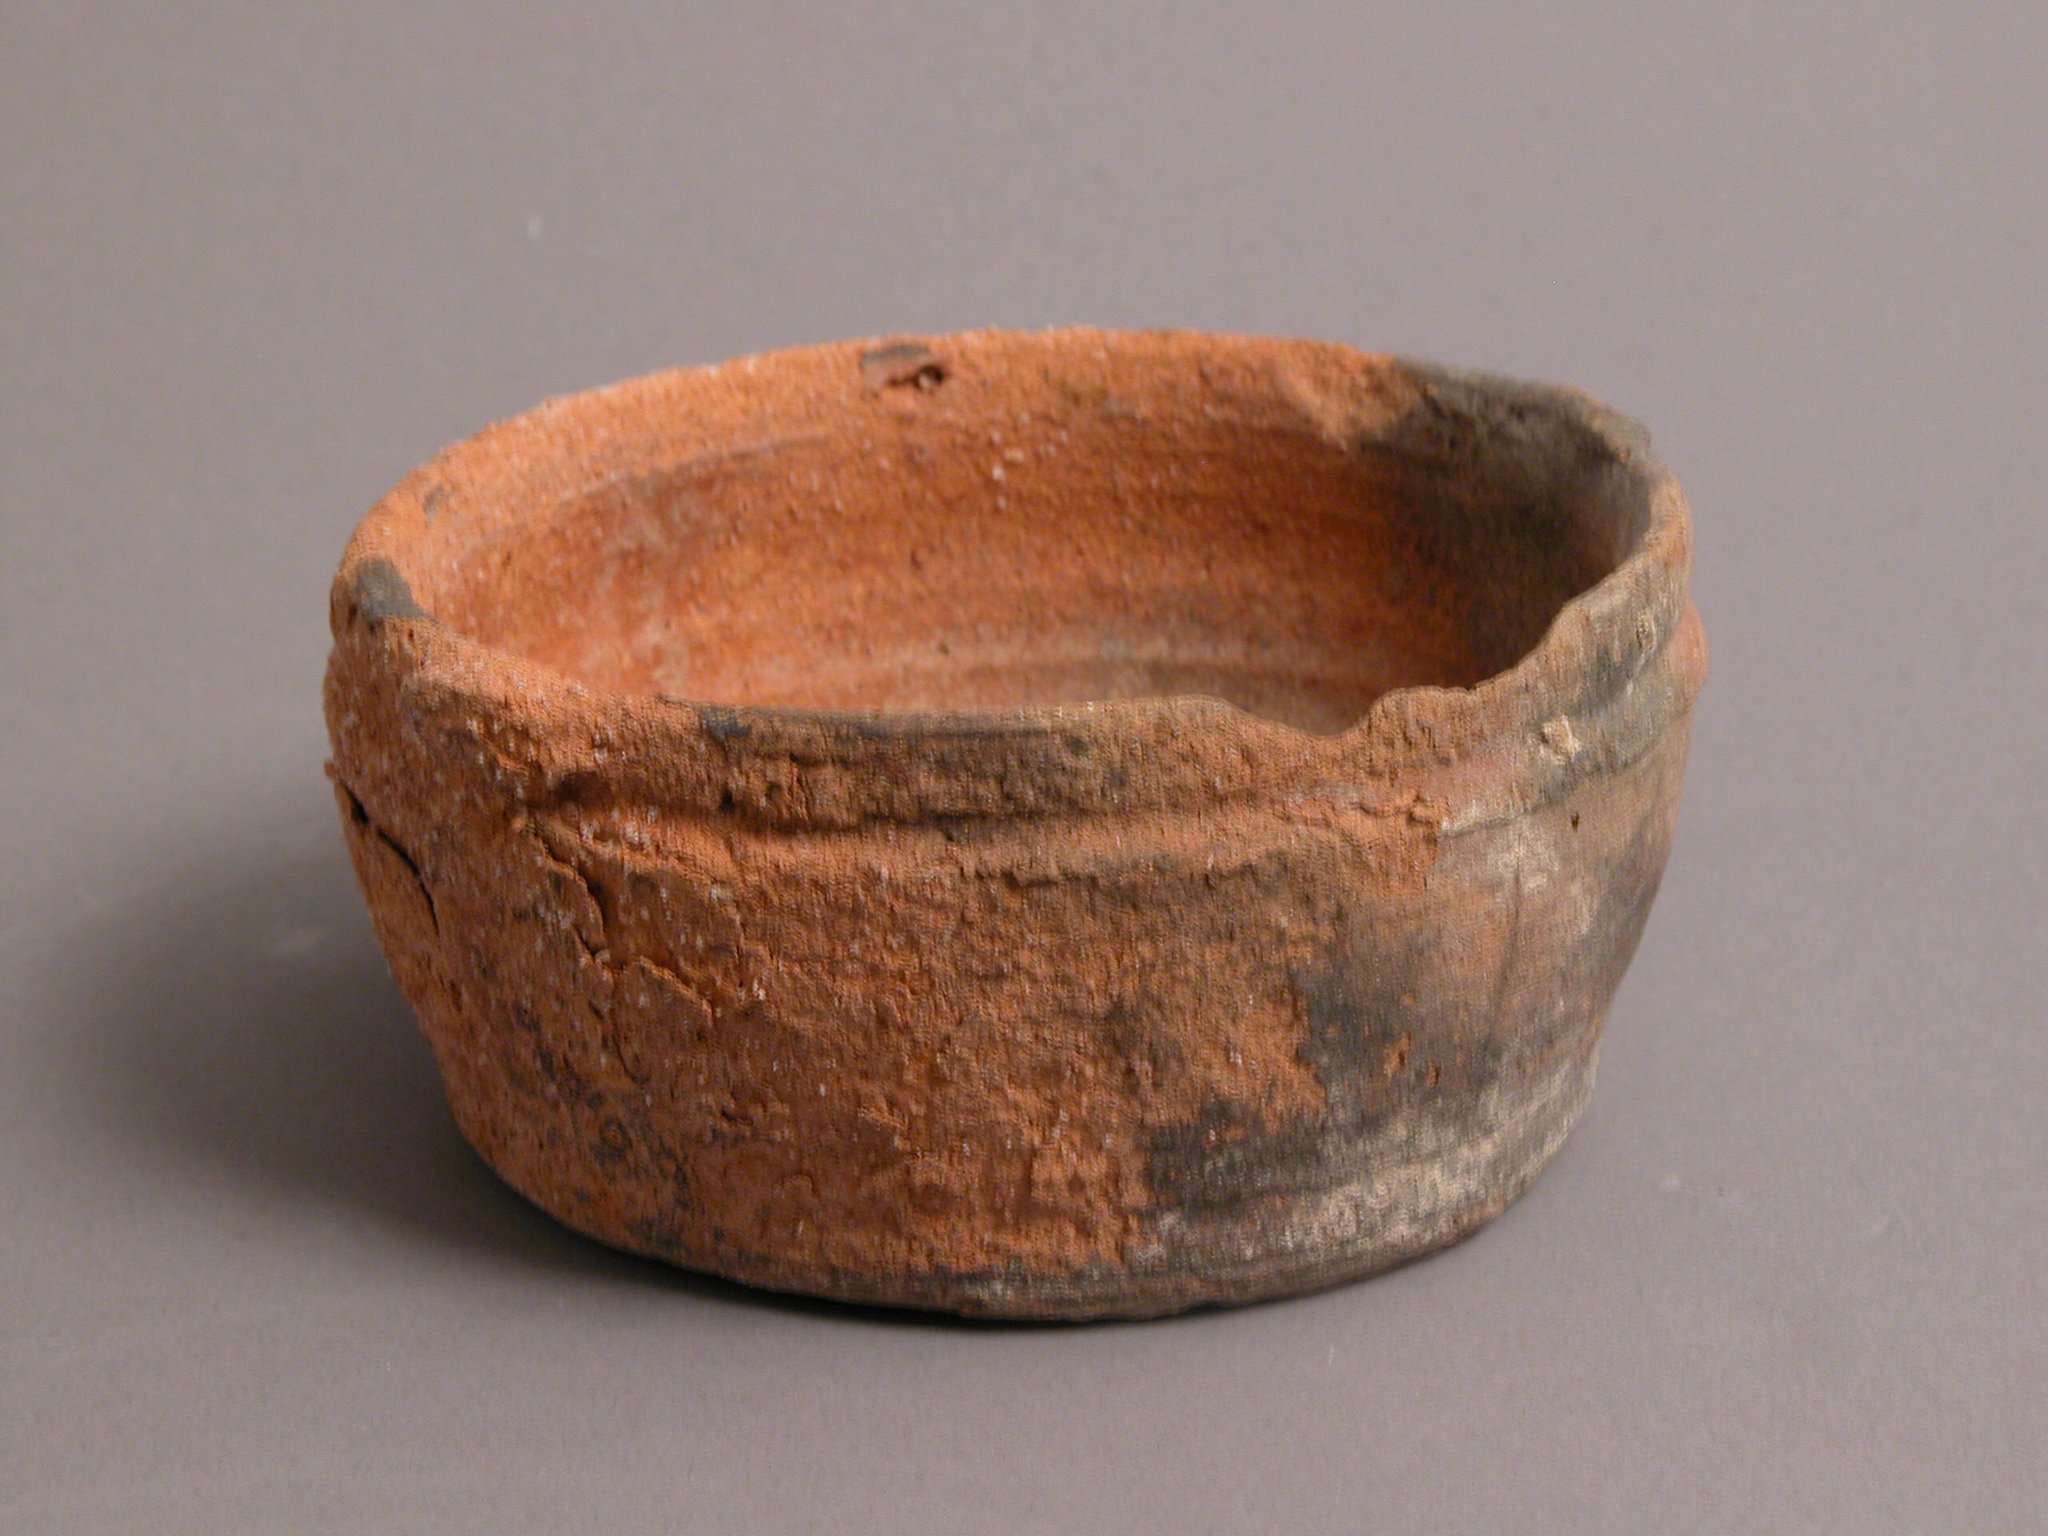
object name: bowl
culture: coptic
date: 301-700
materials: earthenware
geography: egypt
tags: bowls